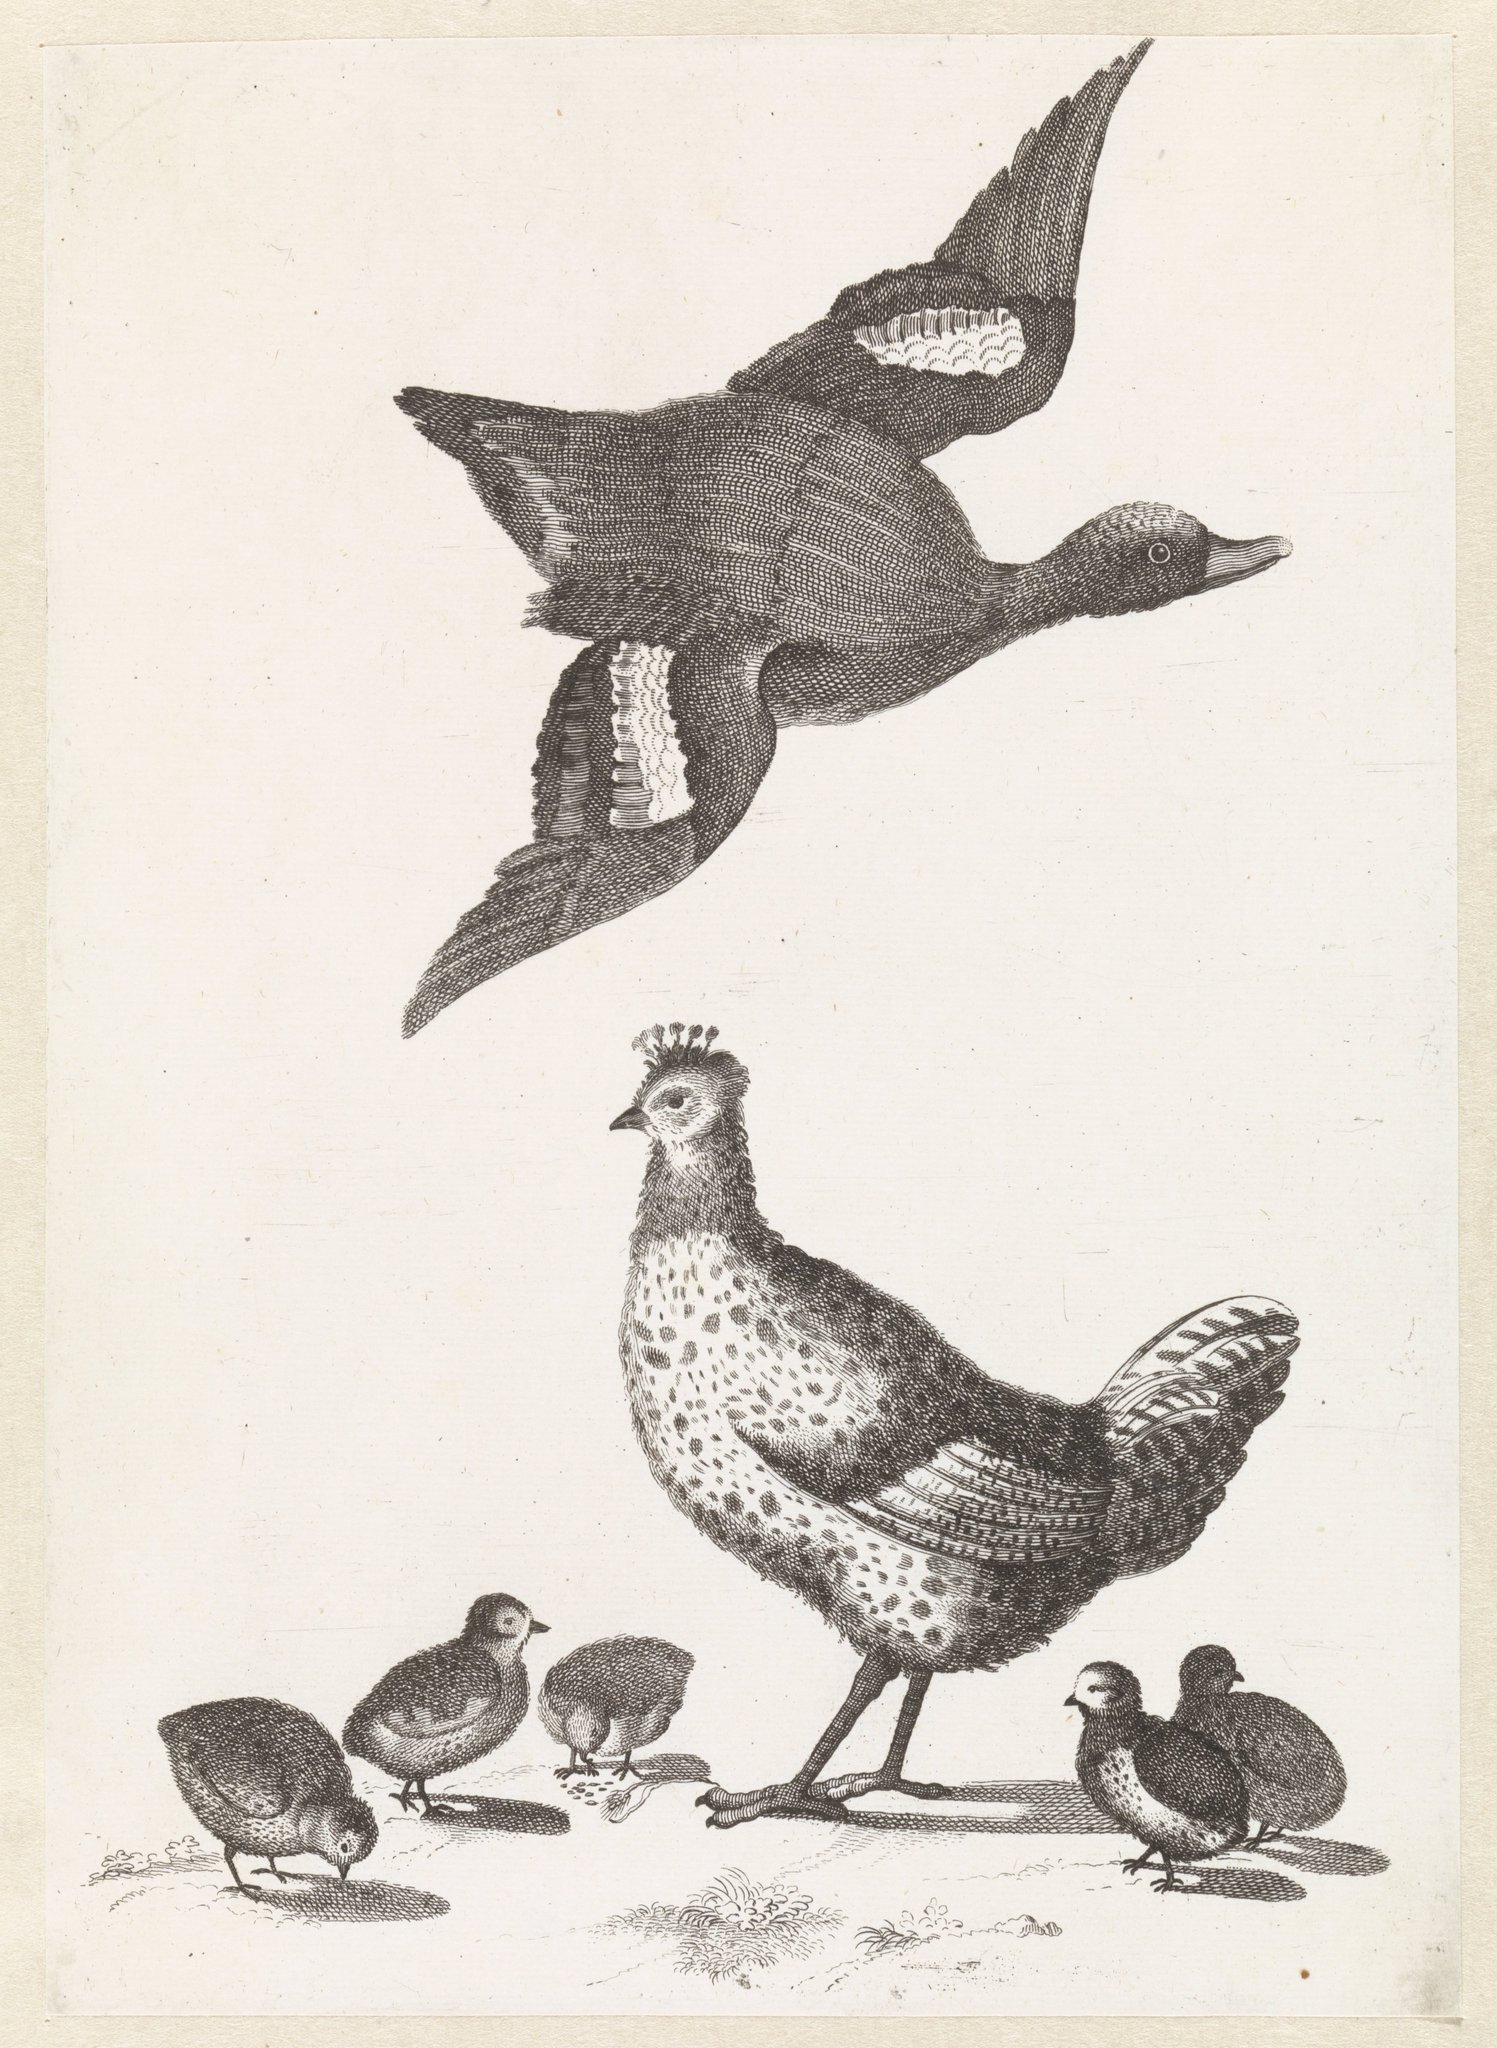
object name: print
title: Kip met vijf kuikens en een naar rechts vliegende eend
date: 1688-1748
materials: paper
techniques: etching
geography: netherlands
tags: fowl (cock, hen, chicken, etc.), water-birds: duck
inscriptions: collector's mark: Lugt 2228